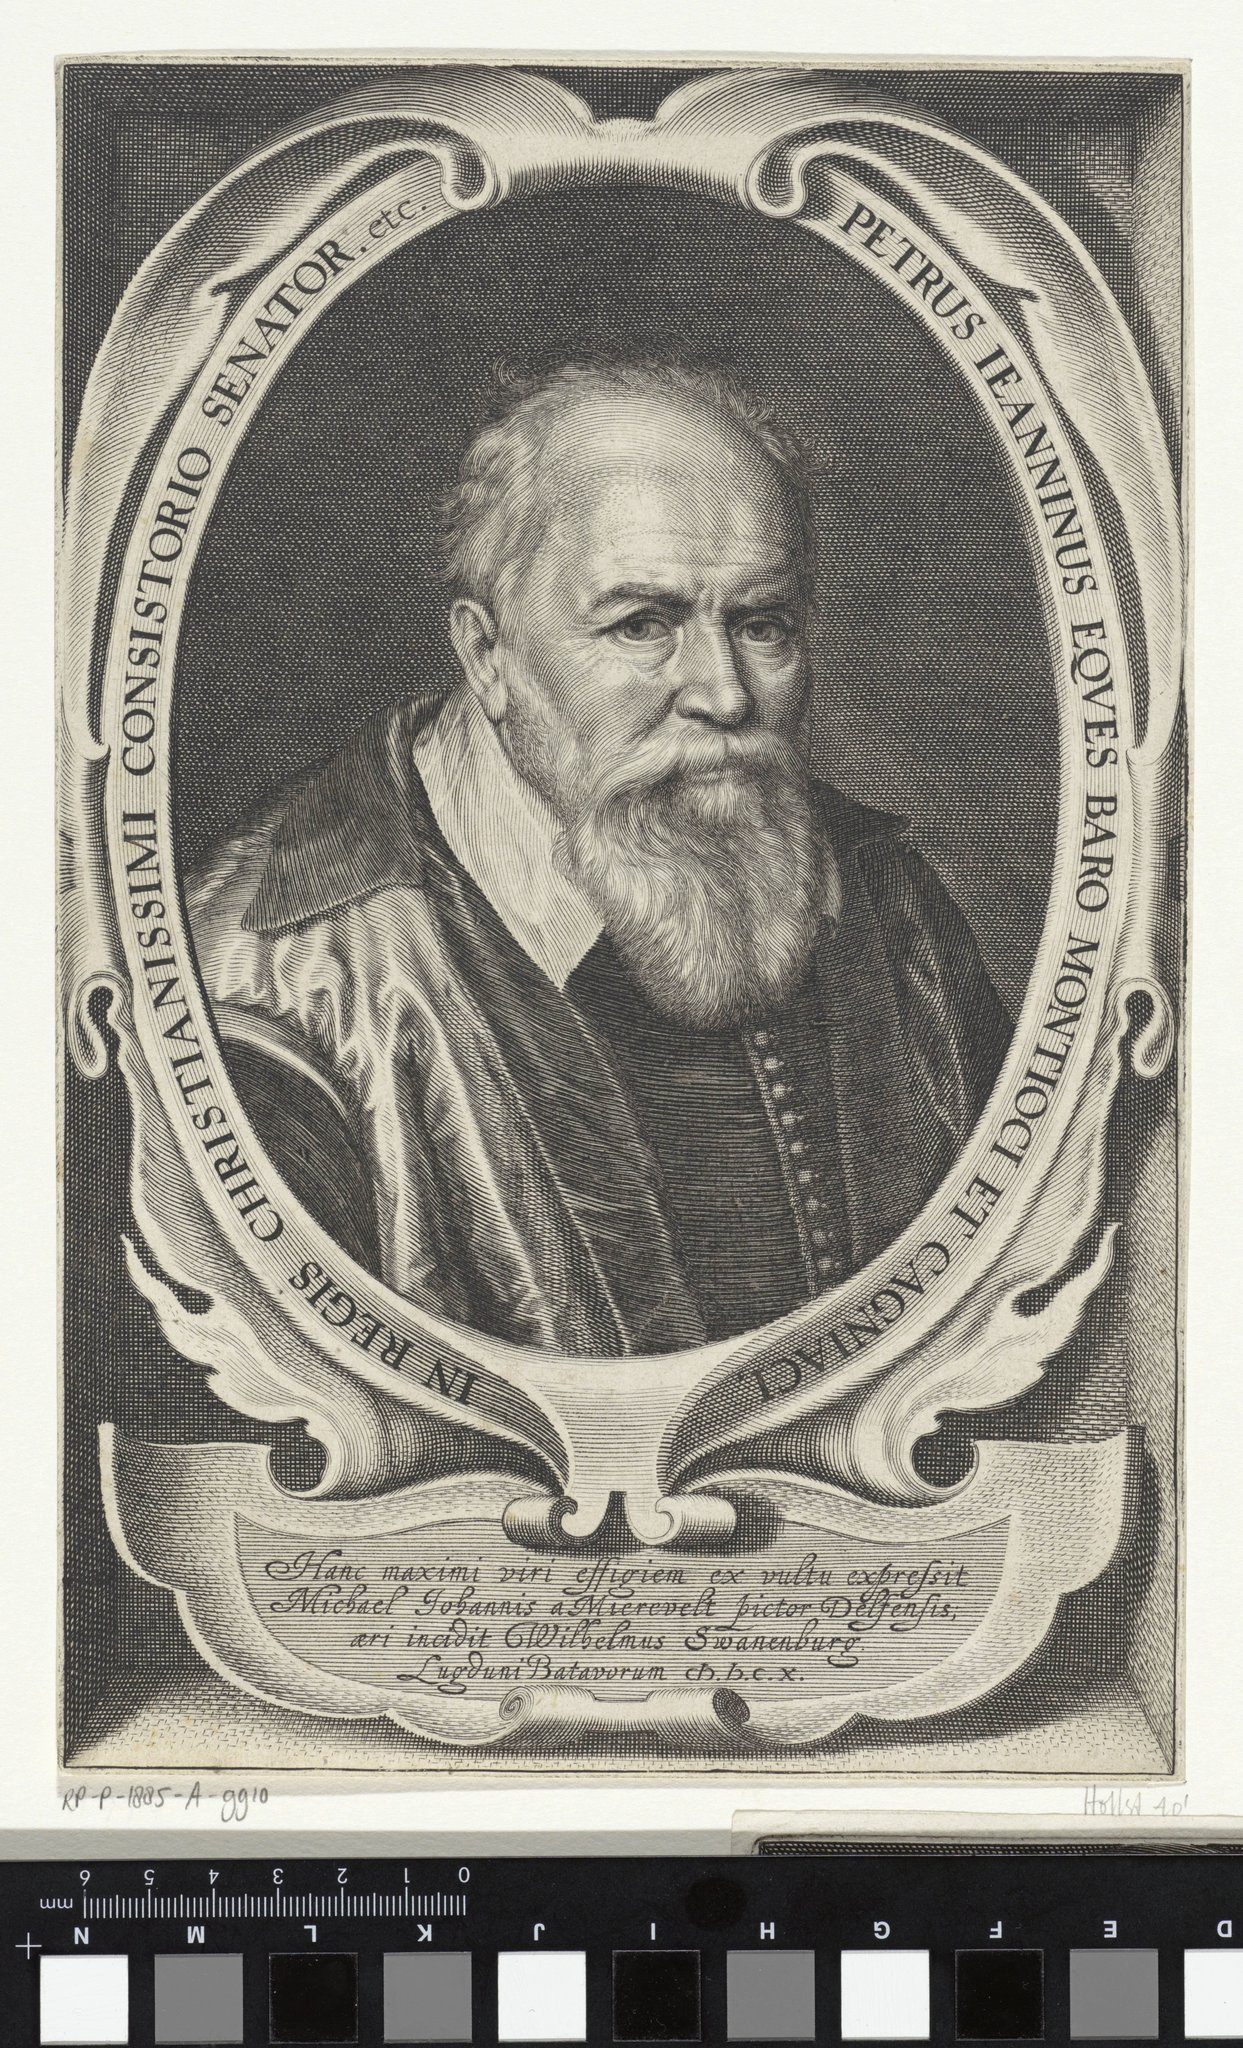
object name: print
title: Portret van Pierre Jeannin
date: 1610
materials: paper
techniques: engraving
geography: leiden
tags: paris, ambassador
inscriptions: collector's mark: Lugt 2228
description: Portret van Pierre Jeannin, afgevaardigde namens Frankrijk bij de vredesonderhandelingen voor het Twaalfjarig Bestand en Frans ambassadeur te Den Haag, in een ornamentele lijst.